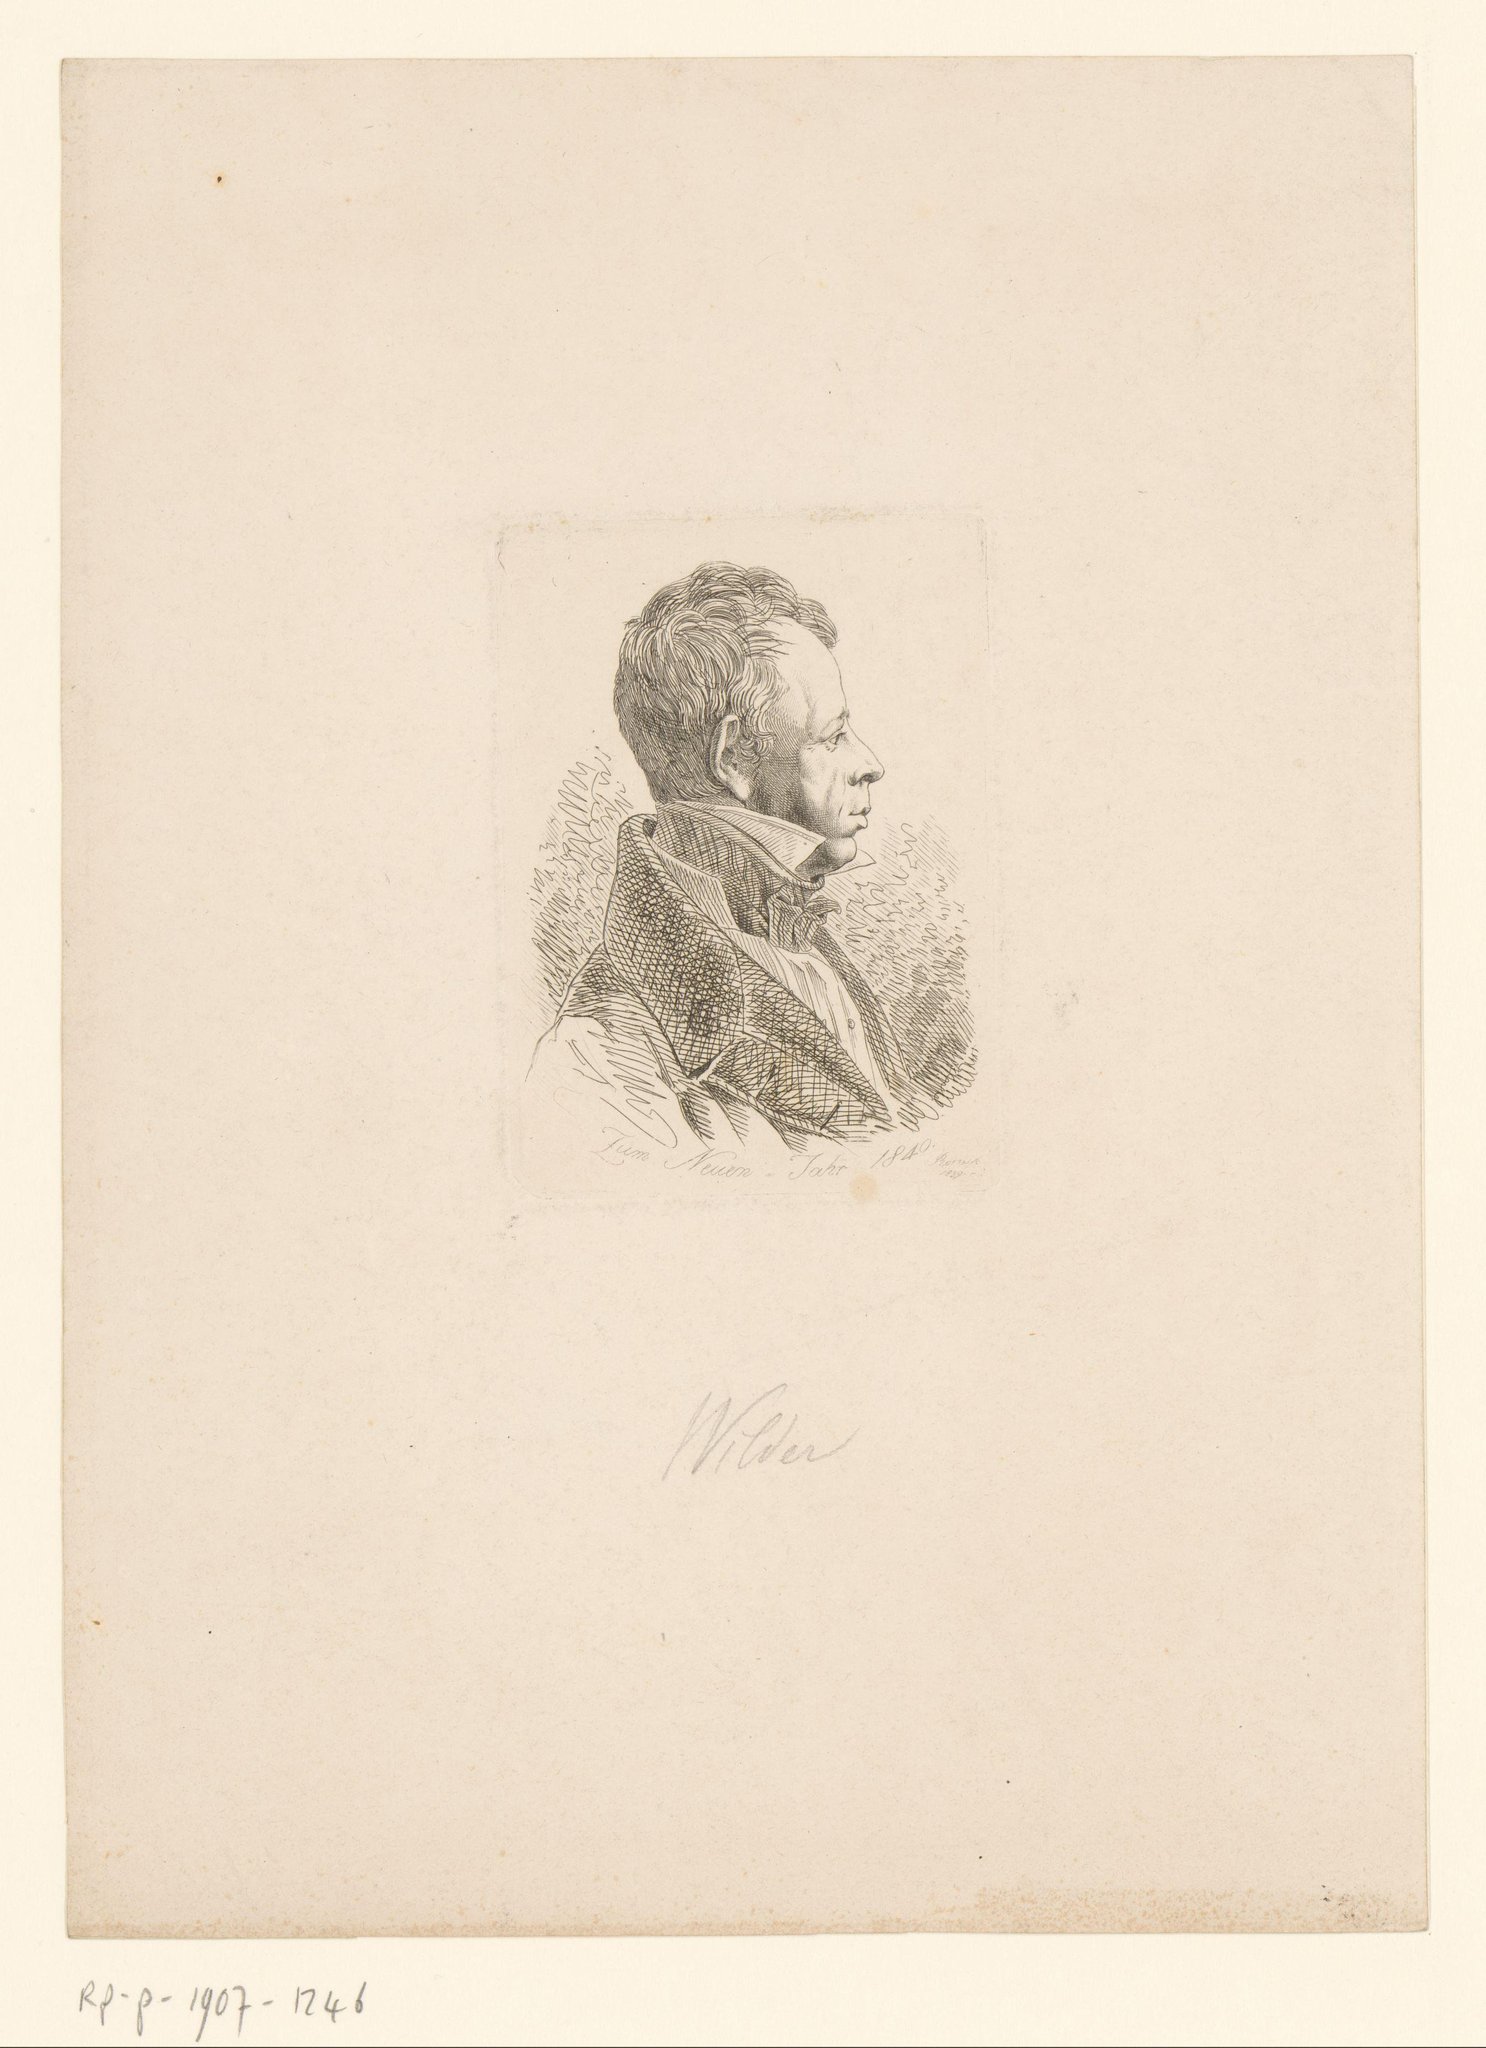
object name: print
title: Portret van Georg Christoph Wilder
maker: christian rosée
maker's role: print maker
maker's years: 1804-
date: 1839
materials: paper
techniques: etching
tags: draughtsman, georg christoph wilder, historical persons, portrait, self-portrait of painter, portrait, self-portrait of graphic artist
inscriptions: collector's mark: Lugt 2228